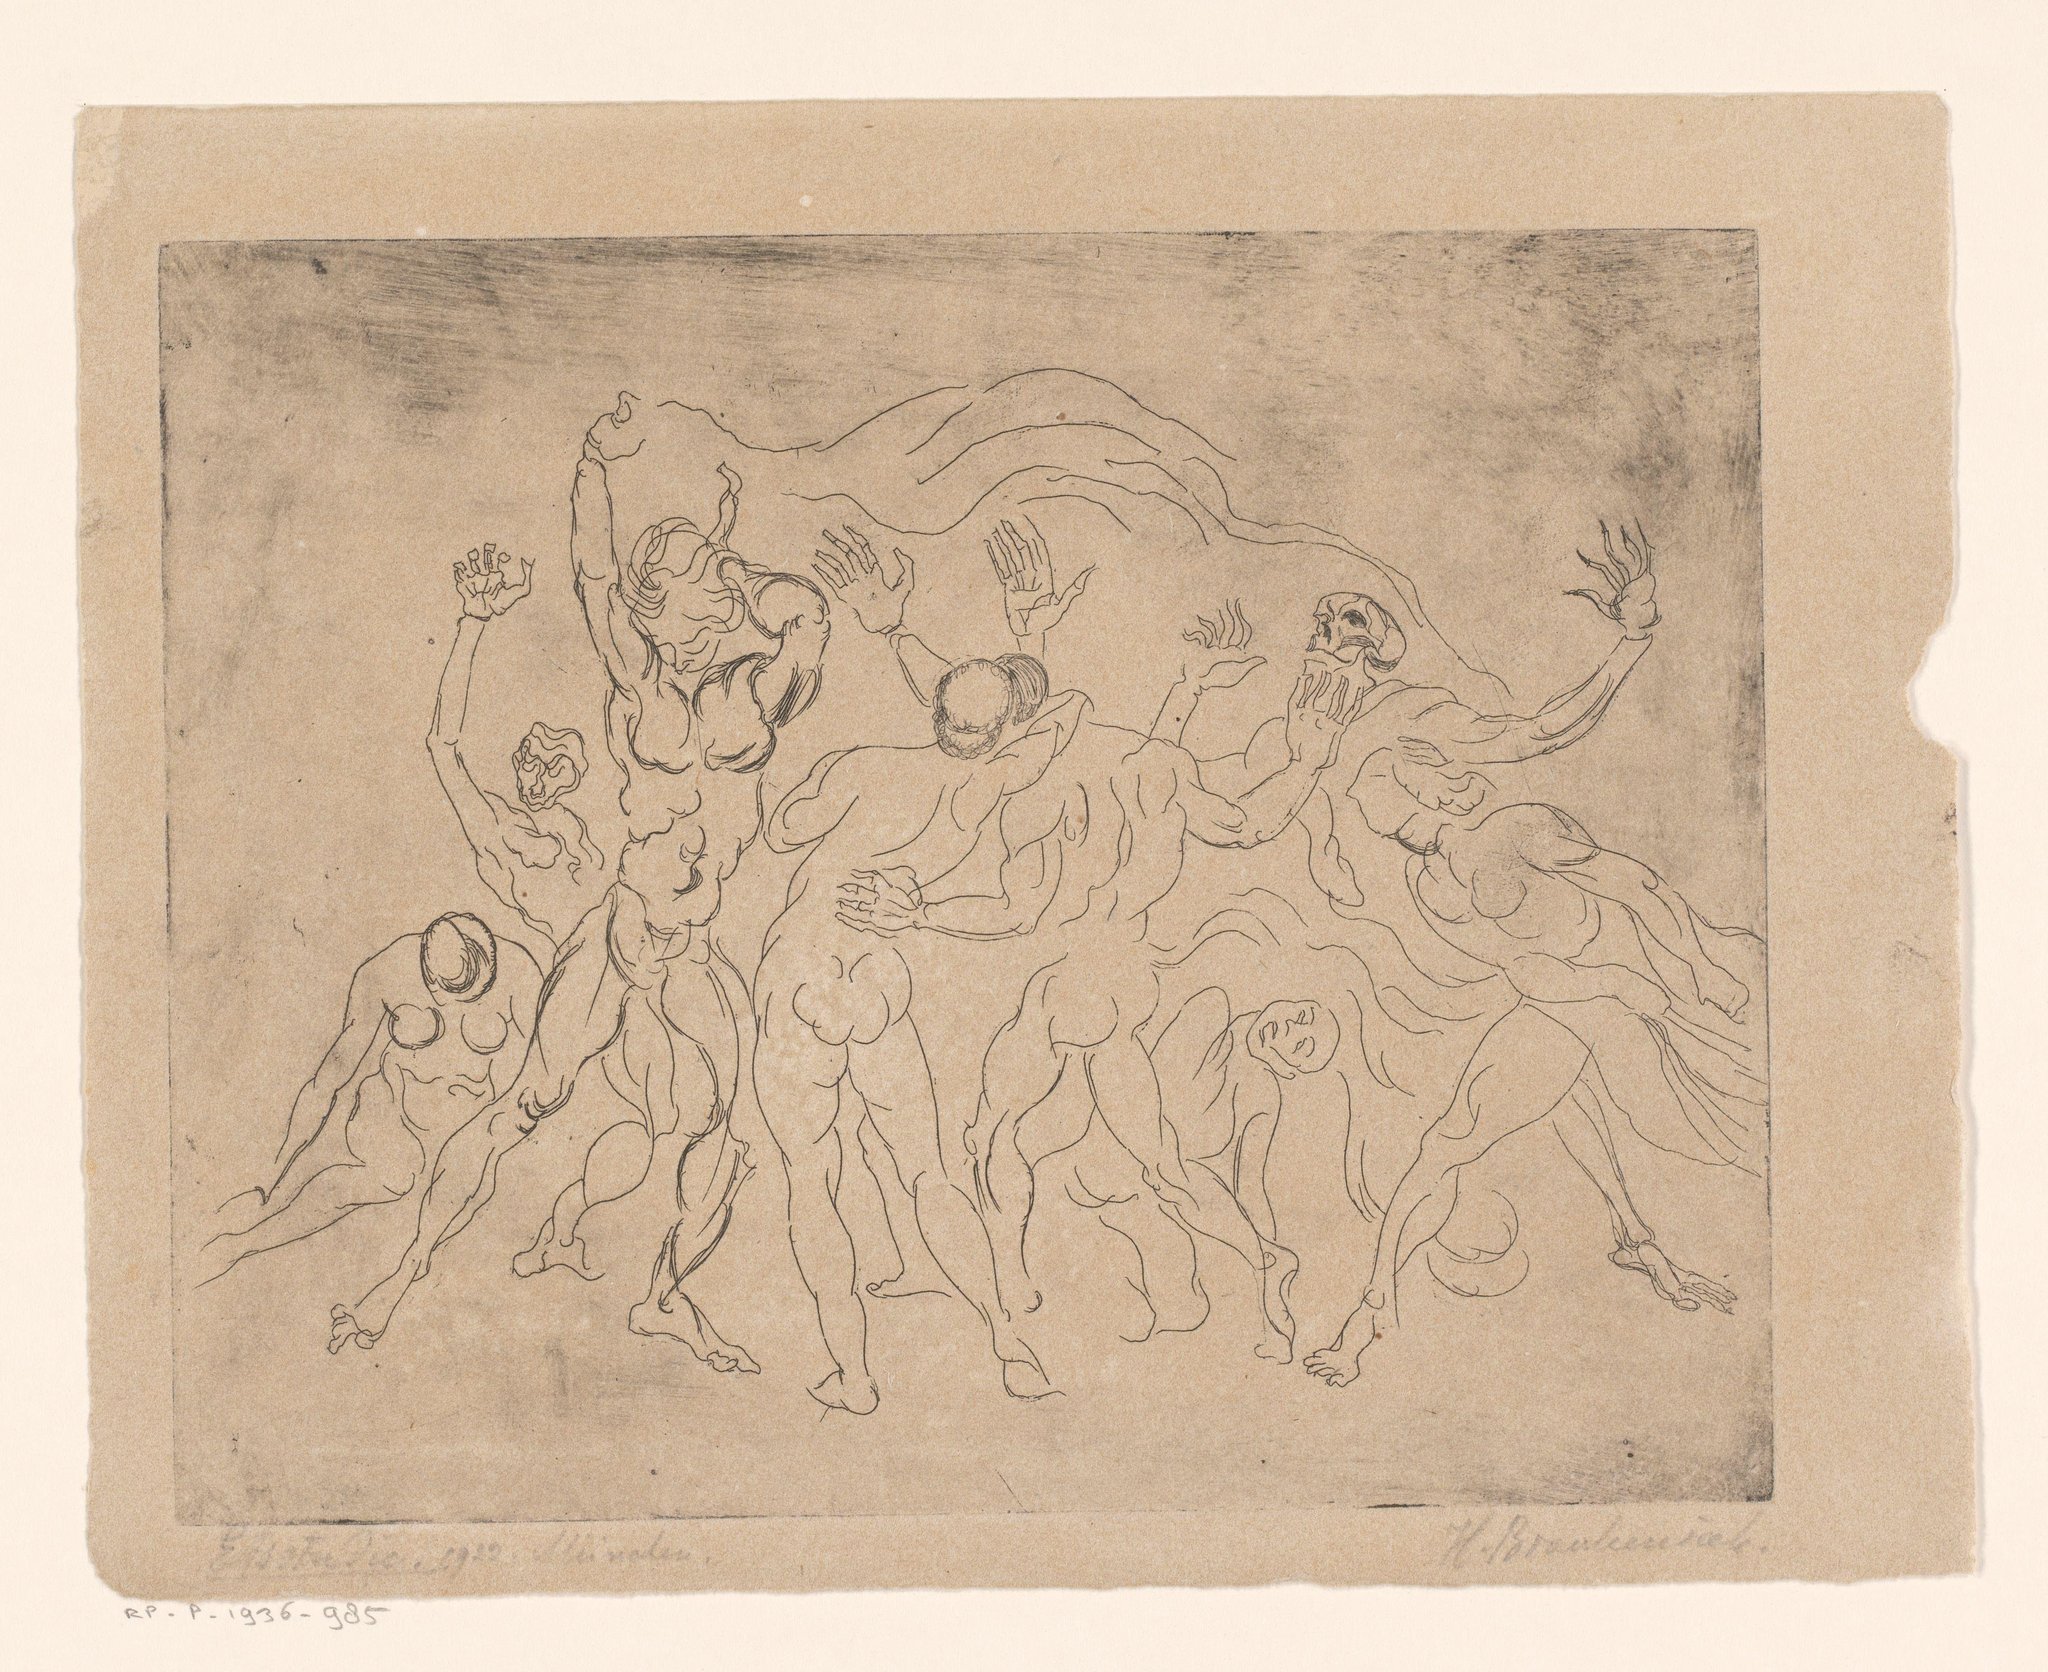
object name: print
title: Fantasie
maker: henri braakensiek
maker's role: print maker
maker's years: 1891-1941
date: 1922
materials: paper, ink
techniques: etching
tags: group dancing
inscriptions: inscription: ‘Ets [?]’, date: ‘1922’, signature: ‘H. Braakensiek.’, collector's mark: Lugt 2228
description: Groep gedeformeerde dansende figuren, met in het midden twee omhelzende naakte mannen op de rug gezien en rechtsboven een schedel.